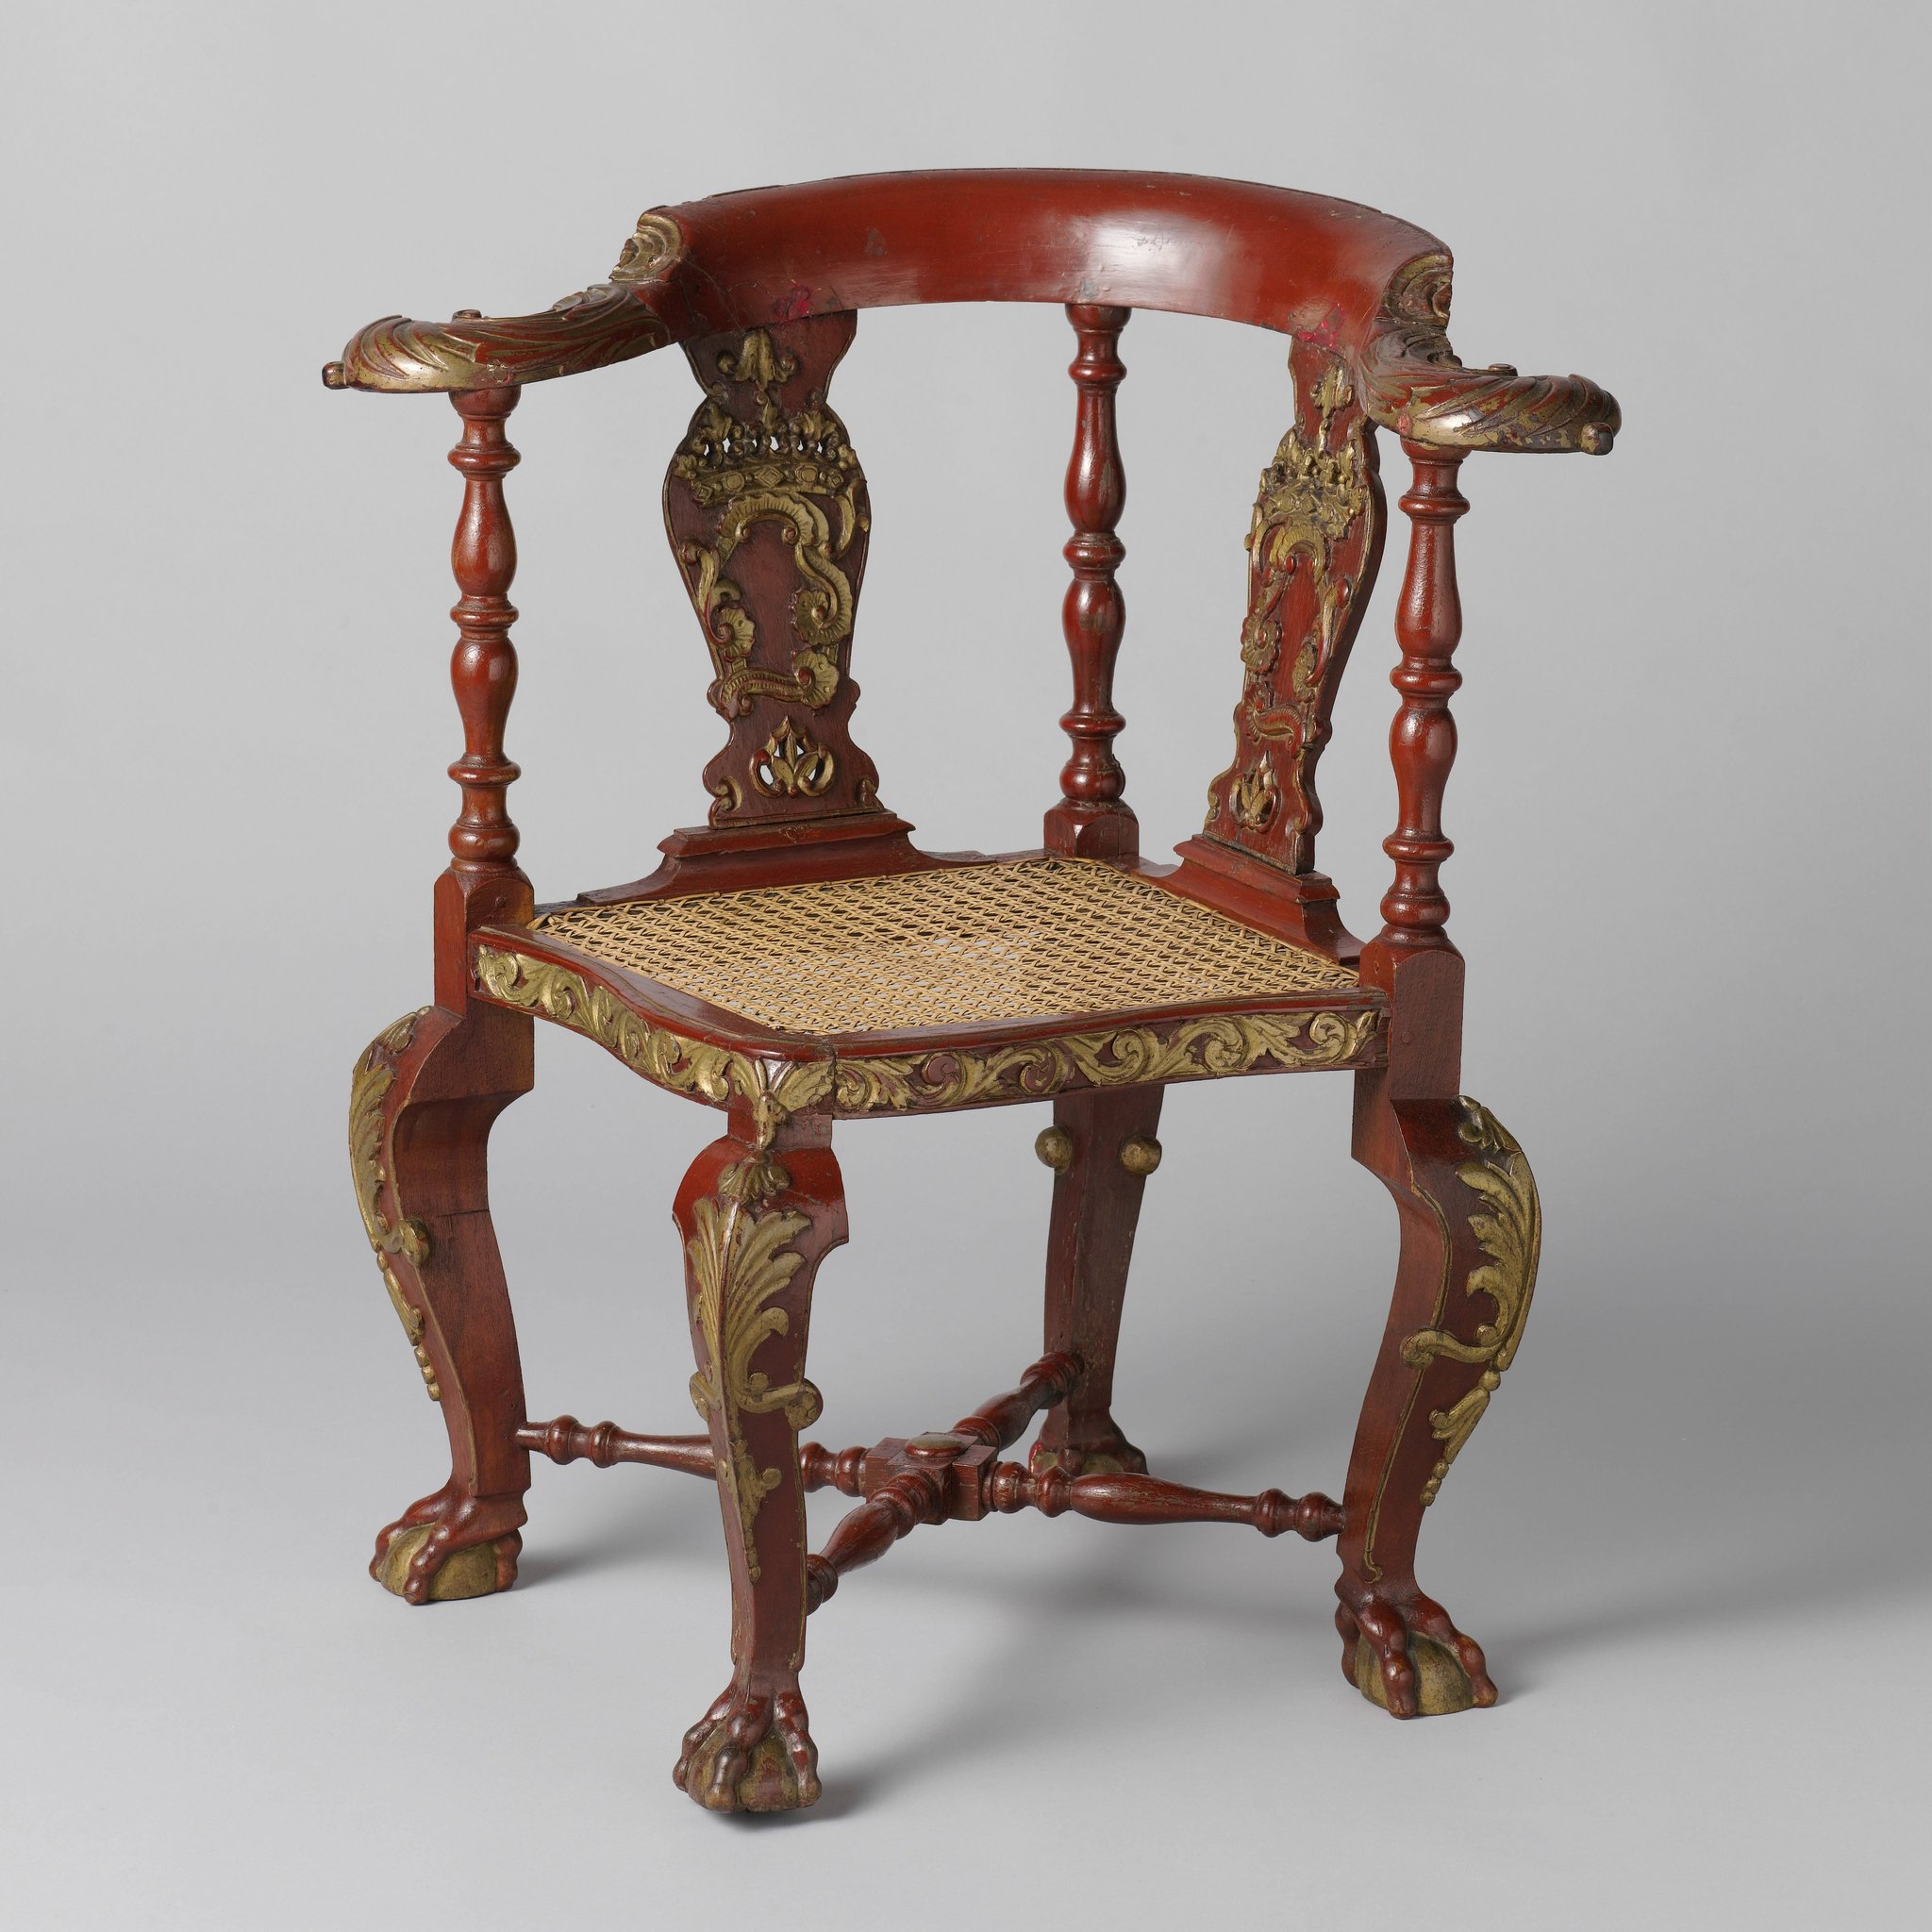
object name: armchair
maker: Anonymous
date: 1750-1760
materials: paint, wood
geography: batavia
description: Two armchairs. Gilded and painted teak. Indonesia, c. 1740 - 1760.